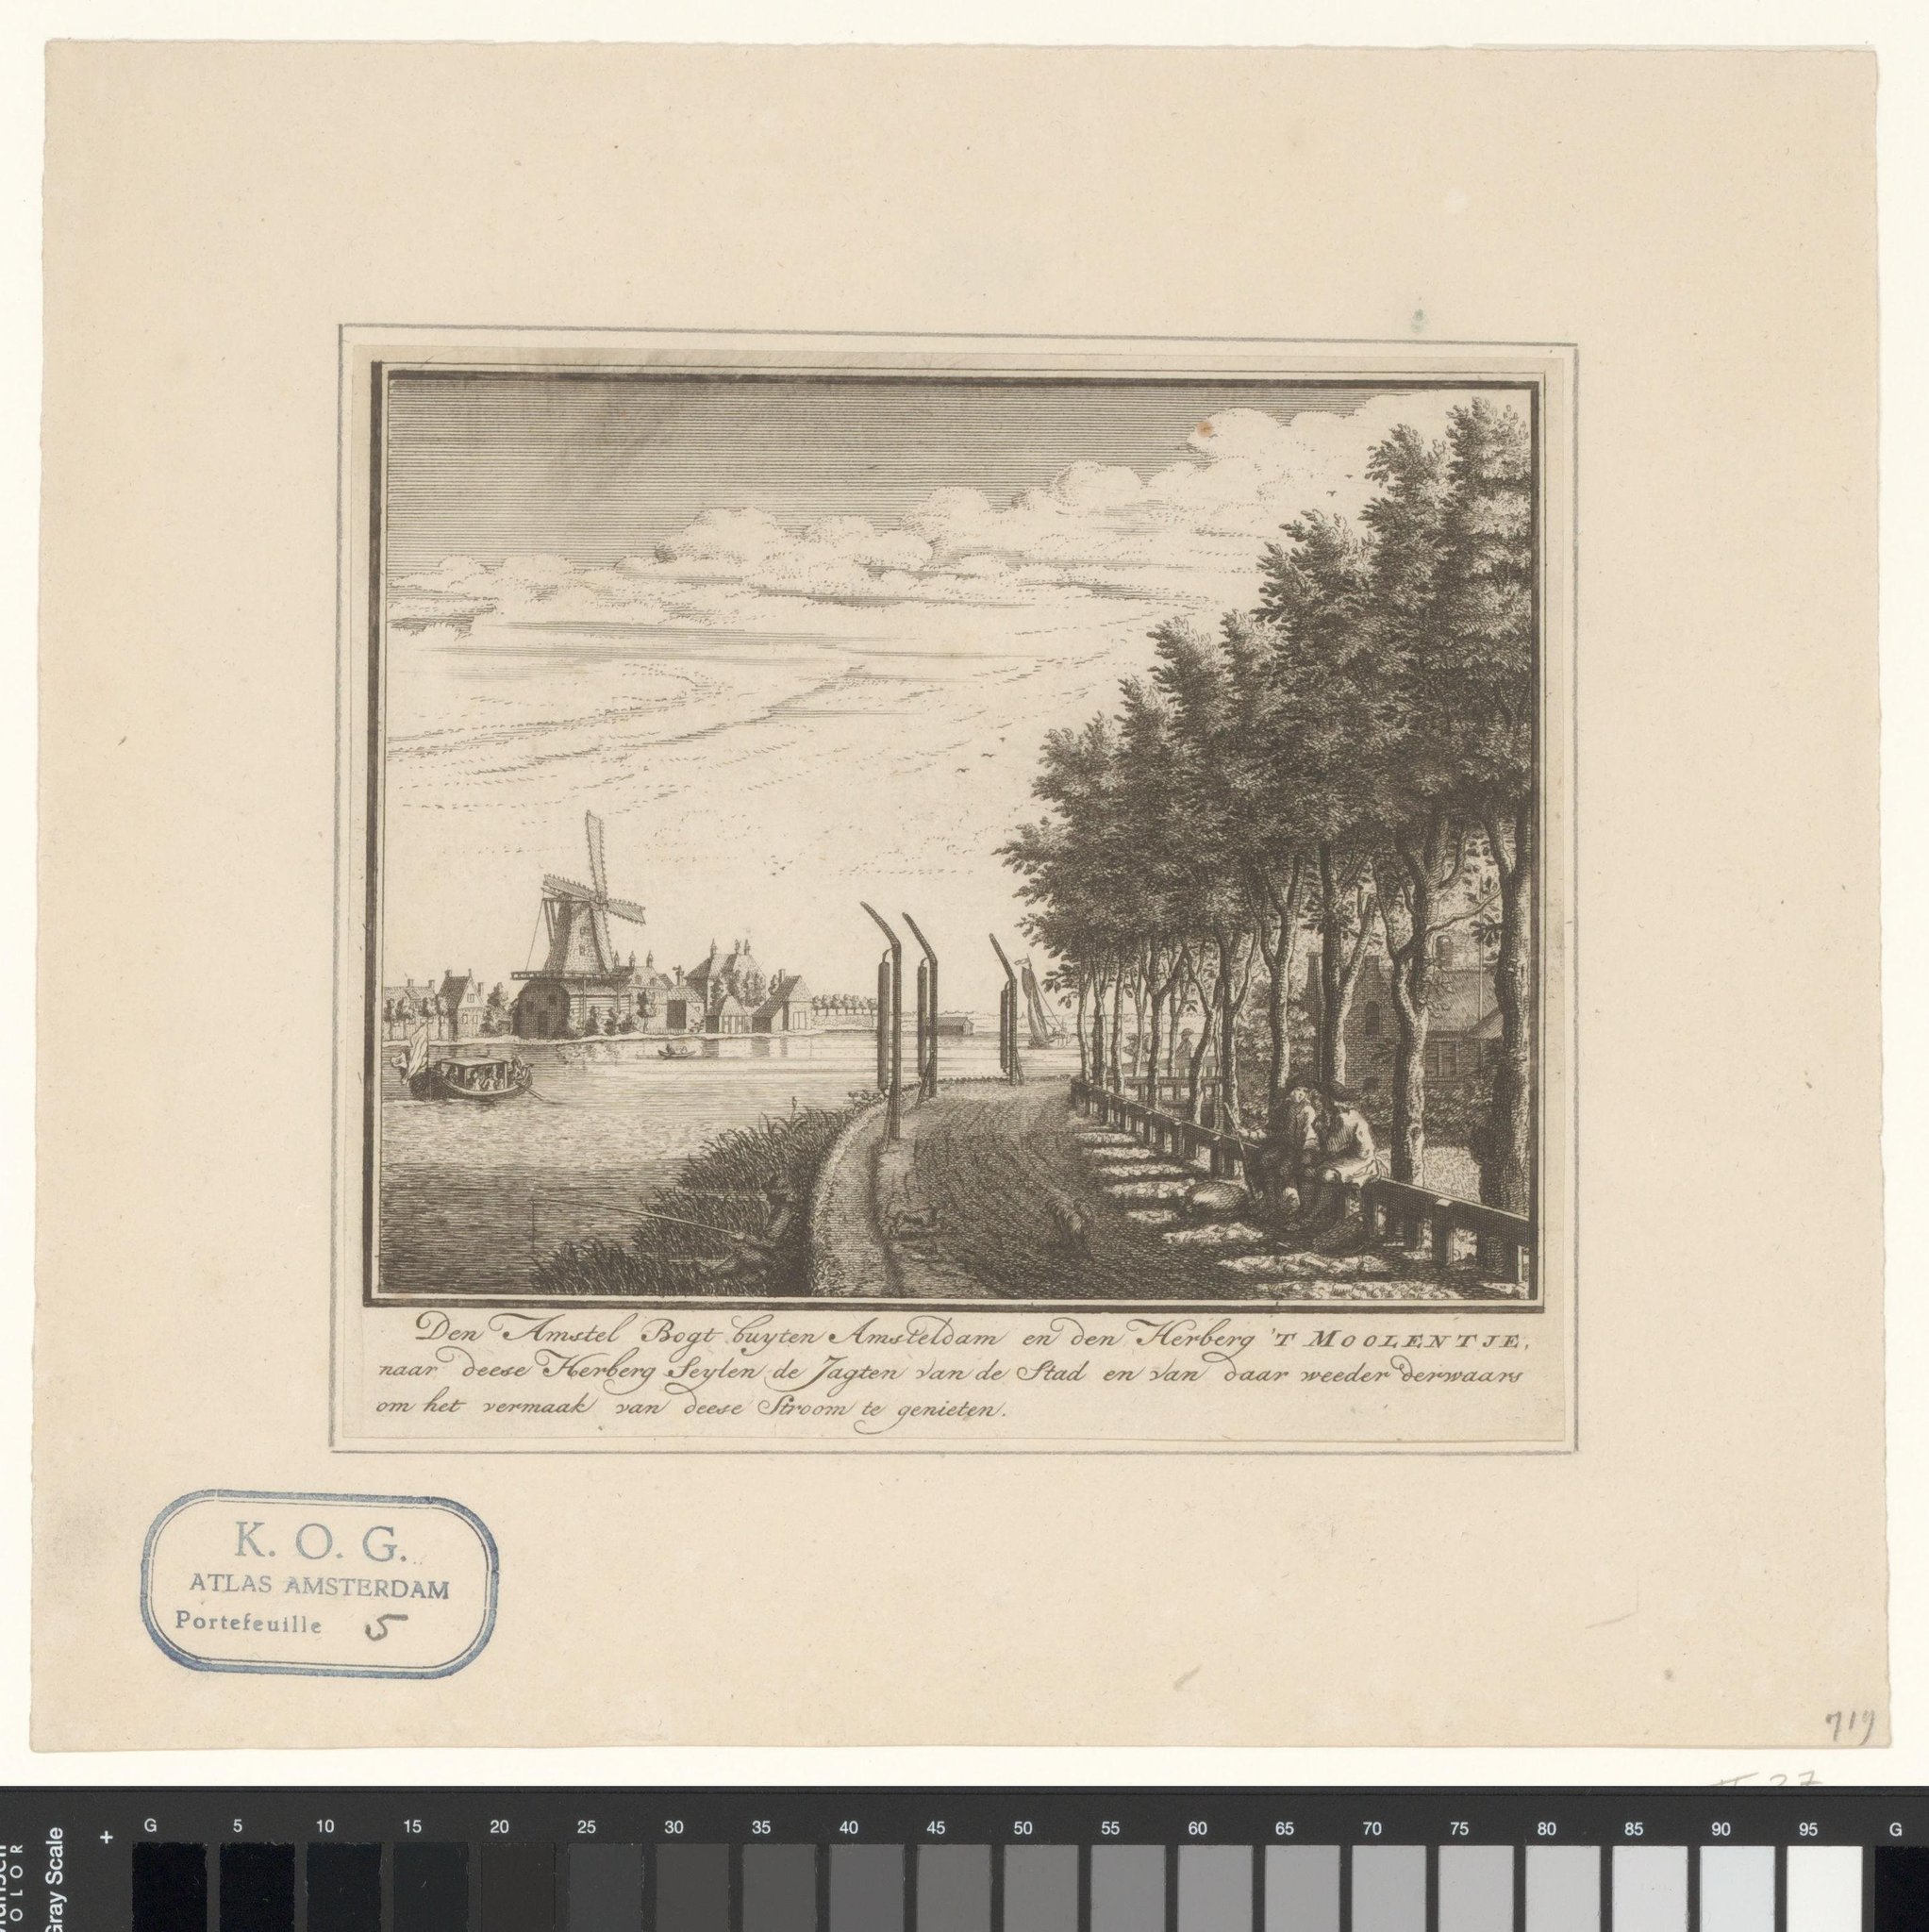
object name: print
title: Gezicht op de Amstel bij herberg het Moolentje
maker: Anonymous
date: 1736-1773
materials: paper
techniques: etching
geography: amsterdam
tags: city-view in general; 'veduta', river, windmill in landscape, angling, boat propelled by man or animal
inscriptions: collector's mark: ‘5’ Lugt 1641b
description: Prent waarschijnlijk uit: Schoemaker, Gerrit et al. Daniel Willinks Amstellandsche Arkadia, of beschryving van de gelegenheit, toestant en gebeurtenissen van Amstellandt, met deszelfs onderhoorige dorpen, heerlykheden, ambachten, lusthoven, wateren, enz. (…). 2 dln. 1e druk. Amsterdam: Arend van Huyssteen, 1737. Of uit: Schoemaker, Gerrit ed. Daniel Willinks Amstellandsche Arkadia, of beschryving van de gelegenheit, toestant en gebeurtenissen van Amstellandt, met deszelfs onderhoorige dorpen, heerlykheden, ambachten, lusthoven, wateren, enz. (…). 2 dln. 2e druk. Utrecht: Samuel de Waal, 1773.